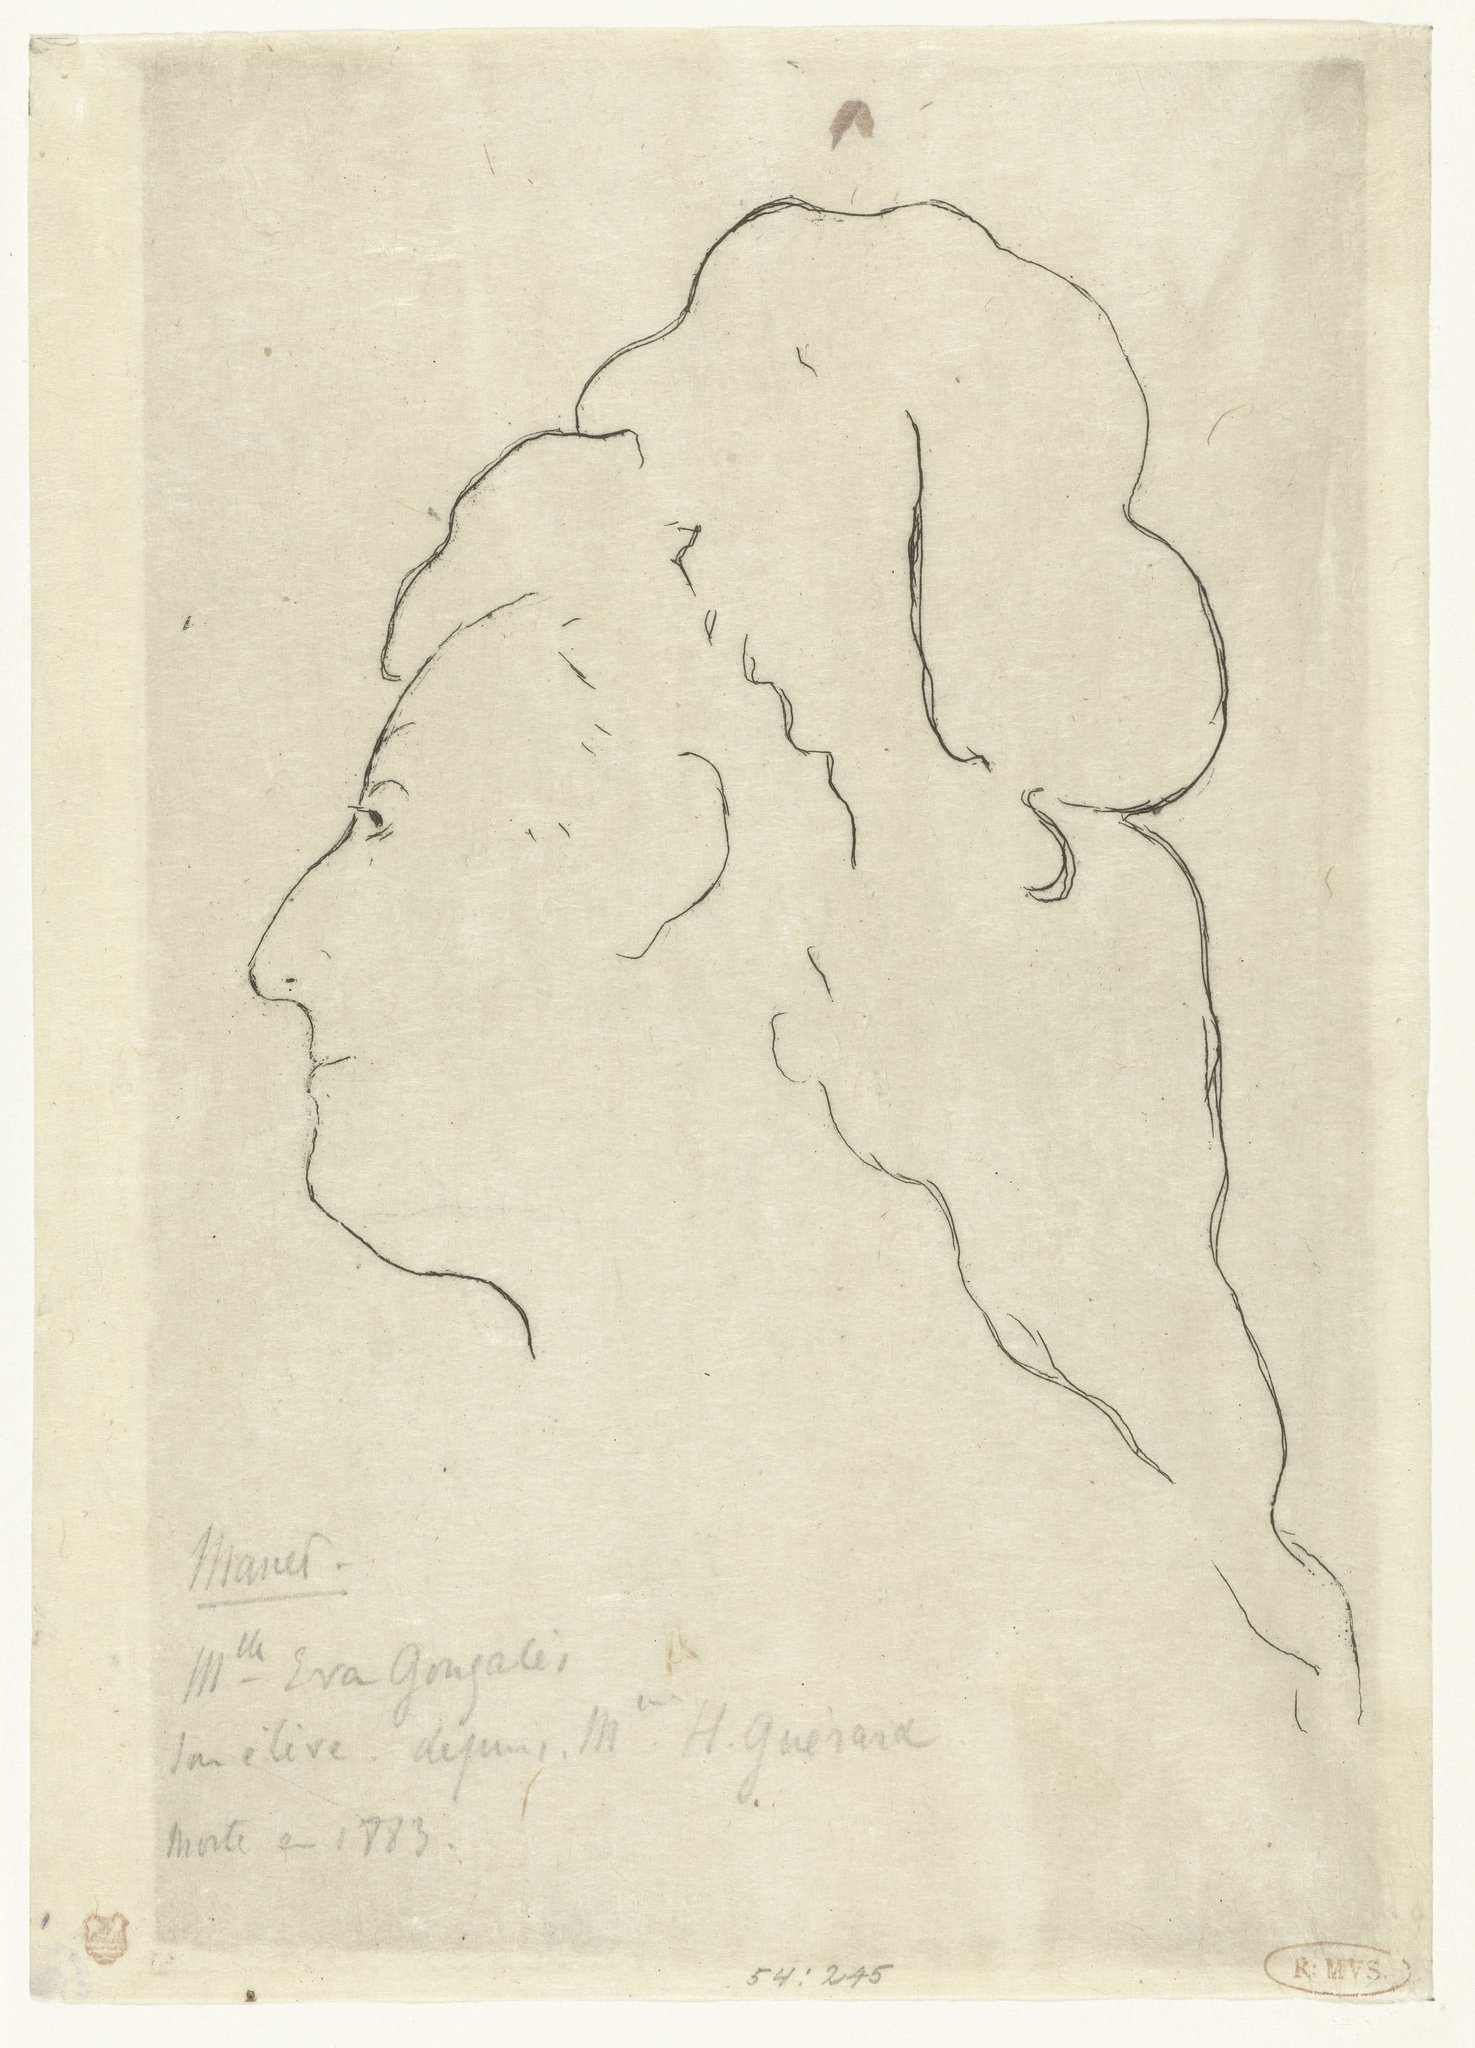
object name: print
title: Portret van Eva Gonzalès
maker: edouard manet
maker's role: painter, print maker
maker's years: 1832-1883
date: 1870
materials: paper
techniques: etching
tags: paris, eva gonzalès, portrait, self-portrait of painter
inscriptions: collector's mark: Lugt 2228, collector's mark: Lugt 2760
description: Deze prent met een annotatie van verzamelaar Burty wordt specifiek genoemd door Guérin 1944, nr. 57. Volgens de auteur maakte de prent deel uit van de collectie Burty en bevond deze zich later in de verzameling van Edgar Degas.